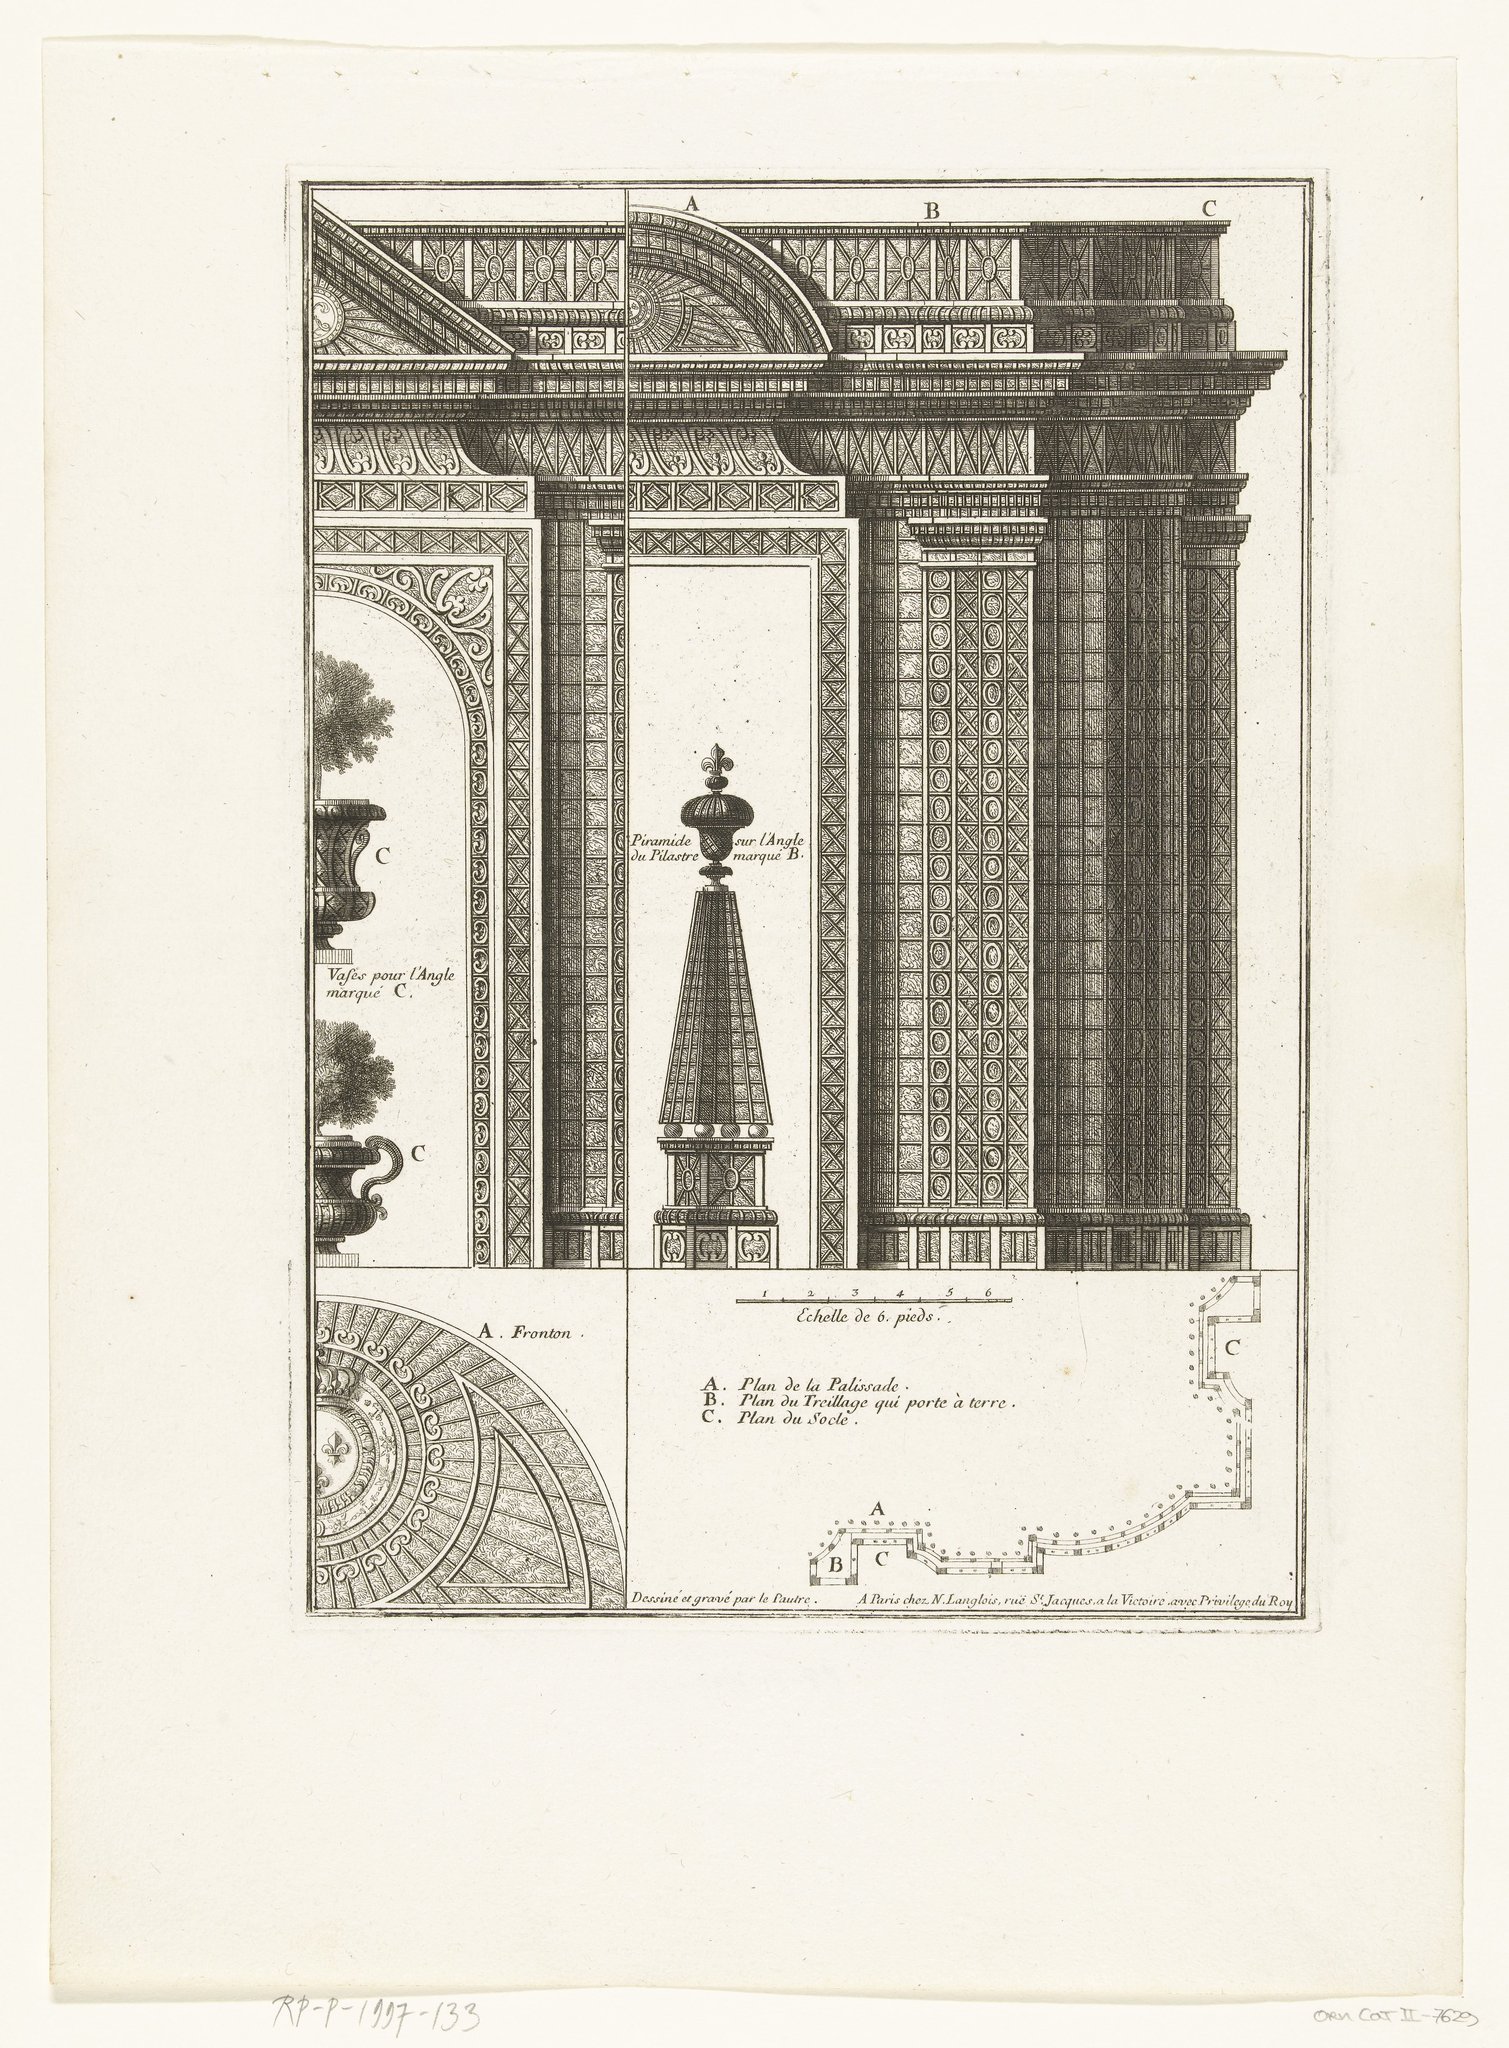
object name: ornament print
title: Latwerkpaviljoens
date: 1670-1703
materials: paper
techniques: etching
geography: france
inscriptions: inscription: ‘In het midden meetlat met tekst: Echelle de 6 pieds. R.o. plattegrond waarboven de tekst: A. Plan de la Pallisade; B. Plan de Treillage qui porte à Terre; C. Plan du Socle. Links fronton met tekst: A. Fronton. Naast de vazen: C. Vases pour l/Angle marqué C; bij de piramide: Piramide sur l'Angle du Pilastre marqué B.’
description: Met opstand, plan en detail van fronton met het Franse koninklijke wapenschild. In het midden staat een obelisk van latwerk bekroond met een vaas en een fleur-de-lis. Uit serie van 6 bladen, tweede editie.